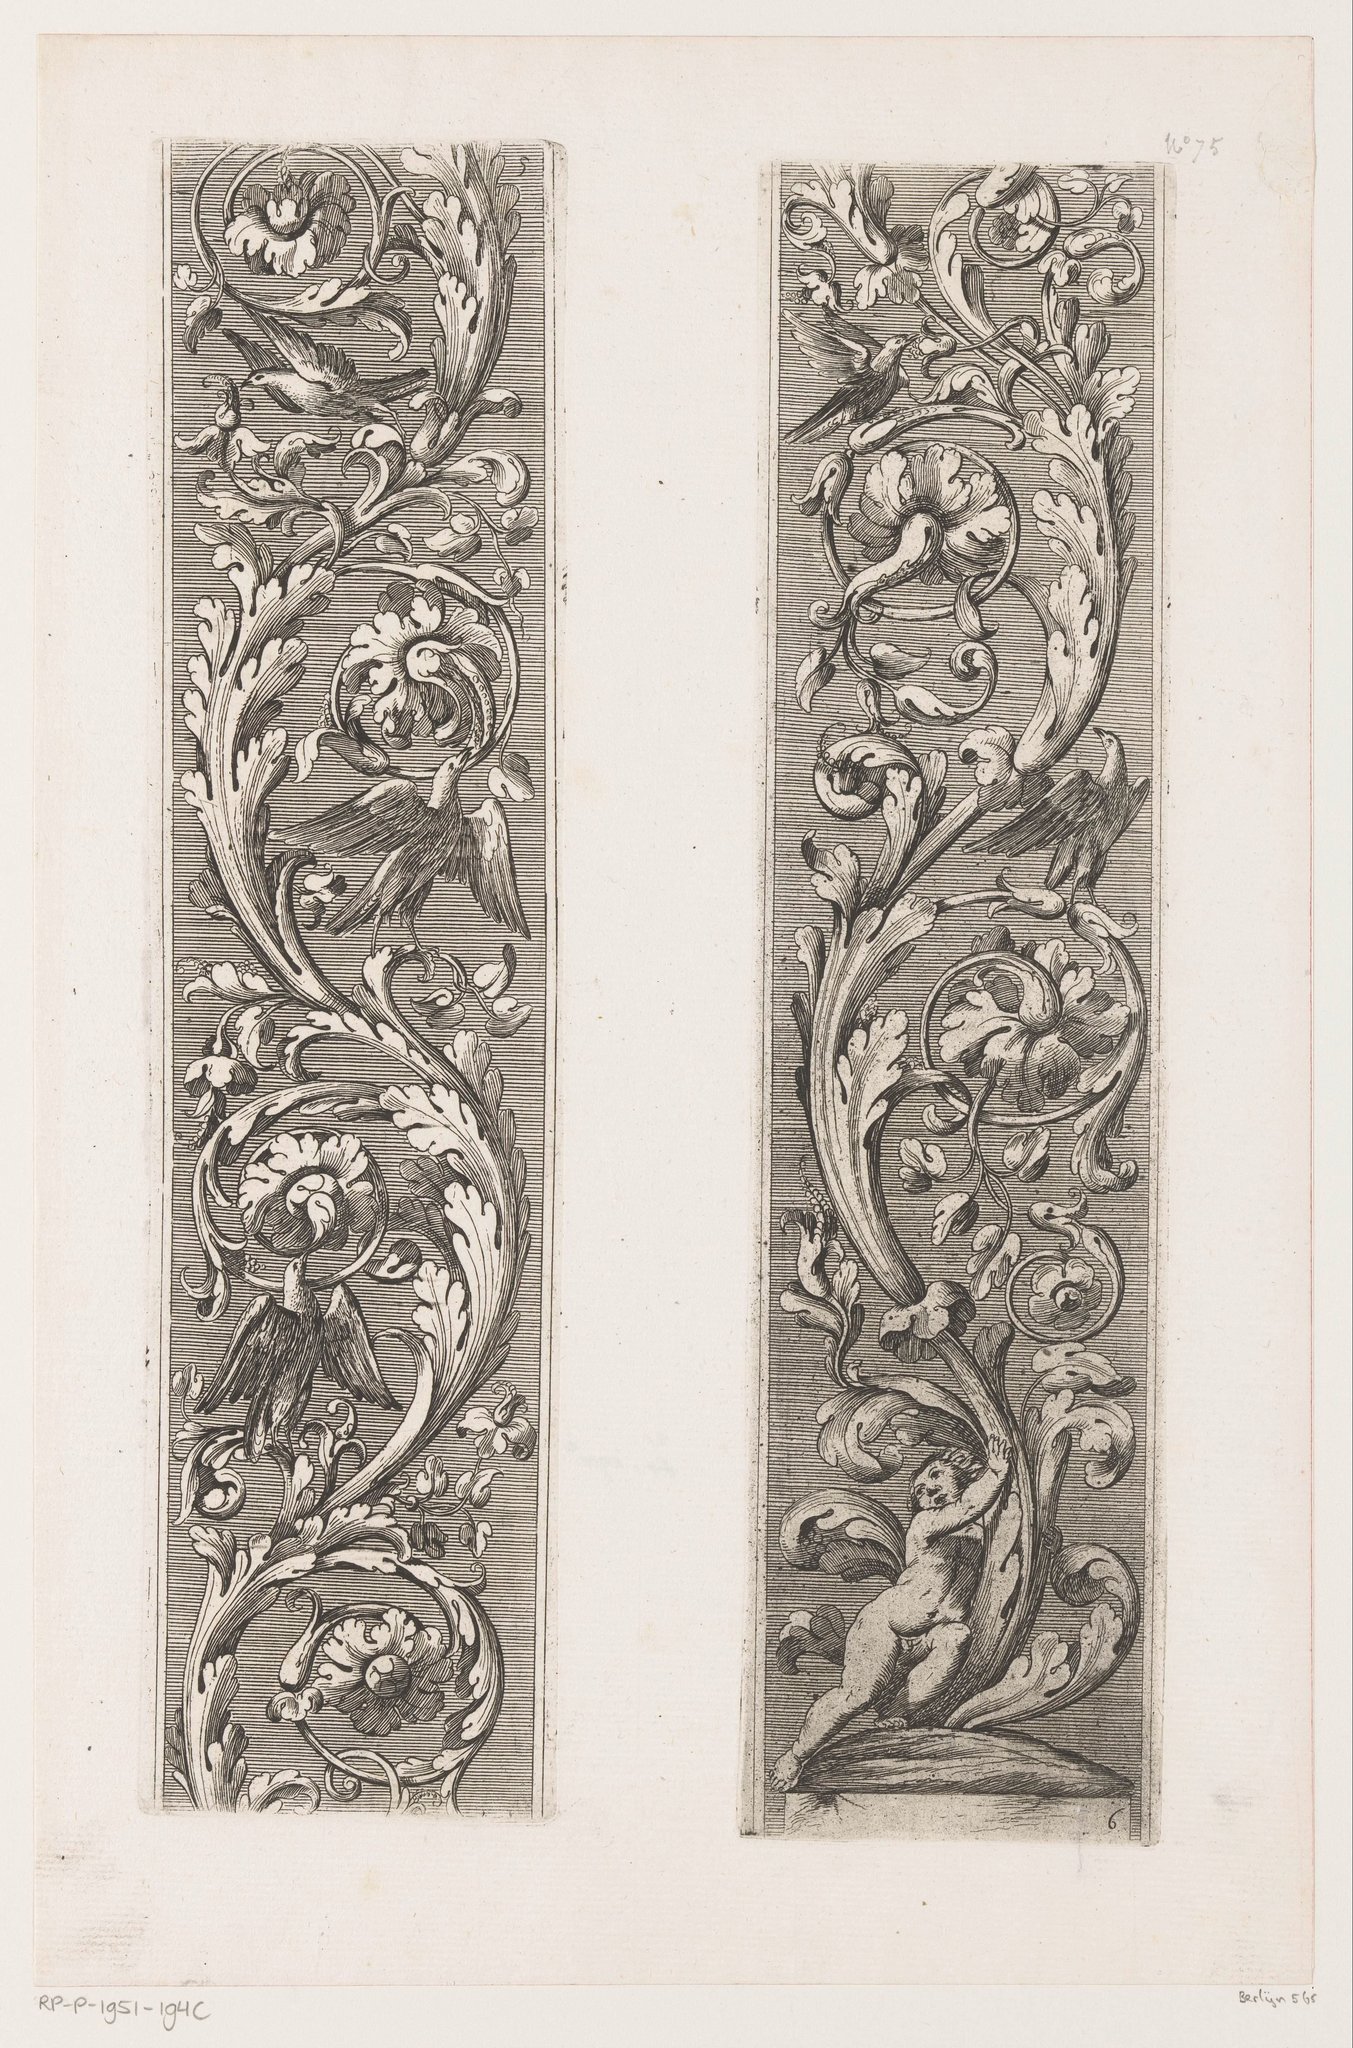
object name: print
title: Freggi dell' Architettura da Agostino Mitelli pittore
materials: paper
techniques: etching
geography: italy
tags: ornament ~ candelabrum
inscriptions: collector's mark: Lugt 2228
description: Deze prent maakt deel uit van een reeks van 48 prenten plus een titelprent. Mitelli maakte tekeningen van marmeren pilasterdecoraties van de poort van de S. Bartolomeo di Porta Ravegnana in Bologna. Deze prenten zijn vervolgens naar die tekeningen gemaakt.